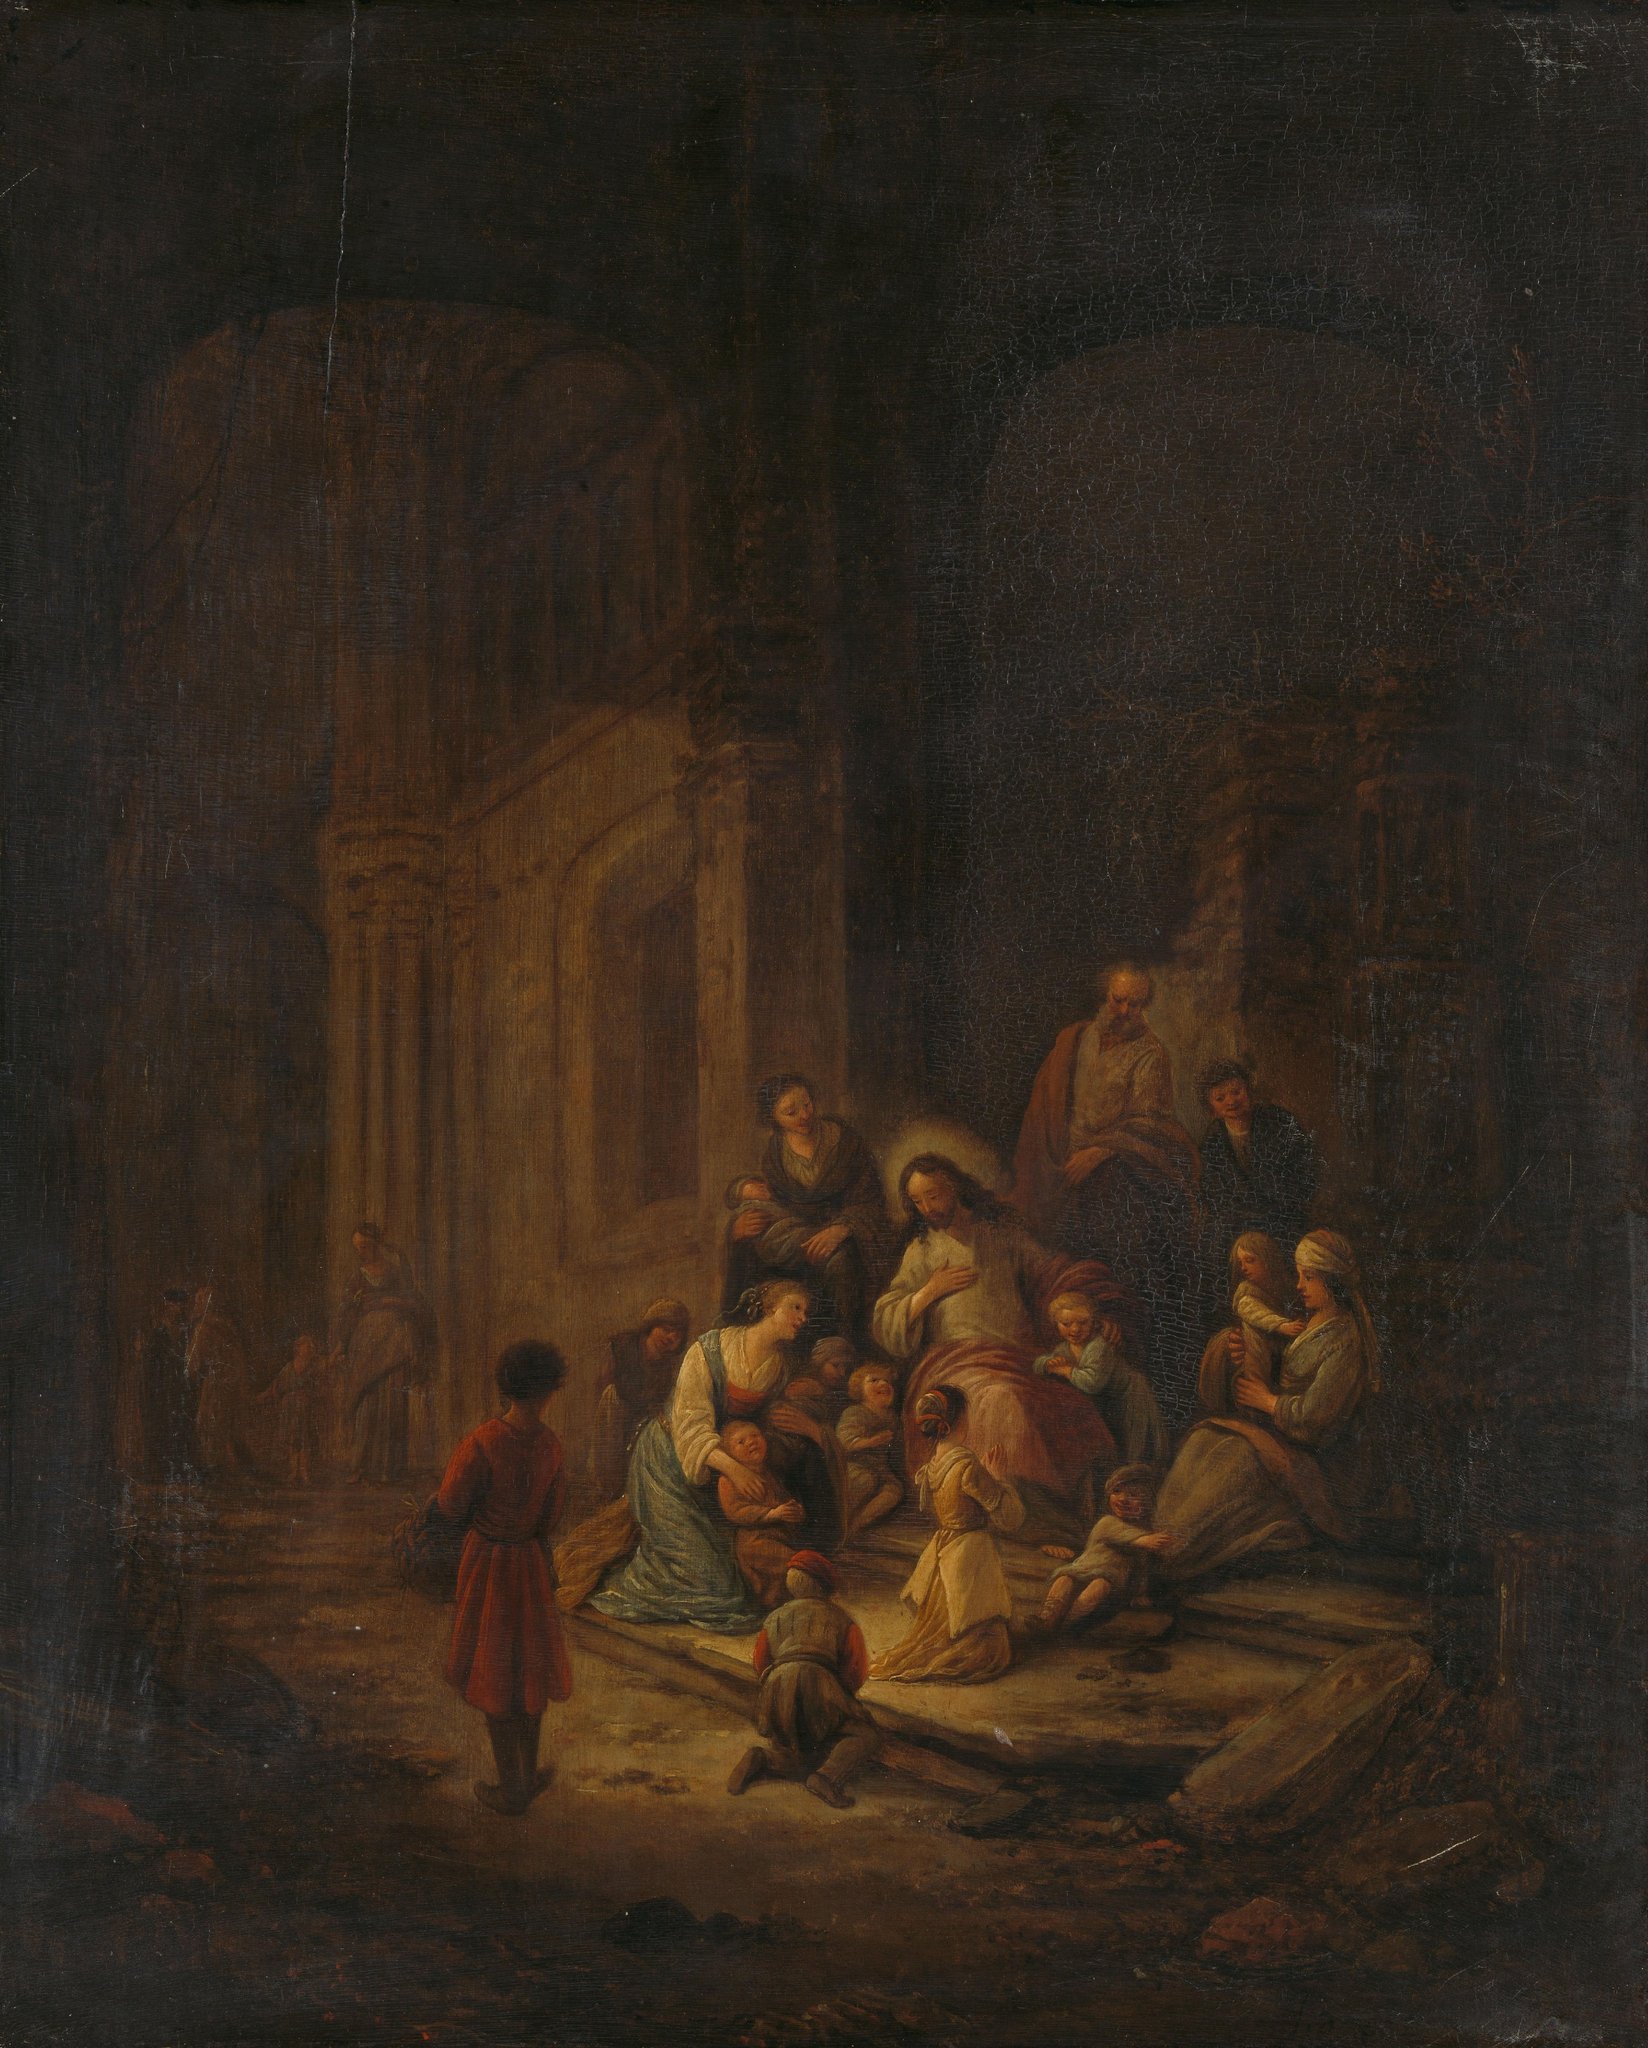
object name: painting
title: Christ Blessing the little Children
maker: jacob de wet (i)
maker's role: painter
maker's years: 1610-1675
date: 1640-1672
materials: oil, panel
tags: christ blessing children brought by their mothers, usually with some disciples disapprovingly looking on (matthew 19:13-15; mark 10:13-16; luke 18:15-17)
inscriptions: signature: ‘J. d. Wet’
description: Christus zegent de kinderen. Christus zit op de trap van een gebouw met bogen nabij een ruïne en zegent de kinderen die bij hem komen, sommigen met hun moeders.